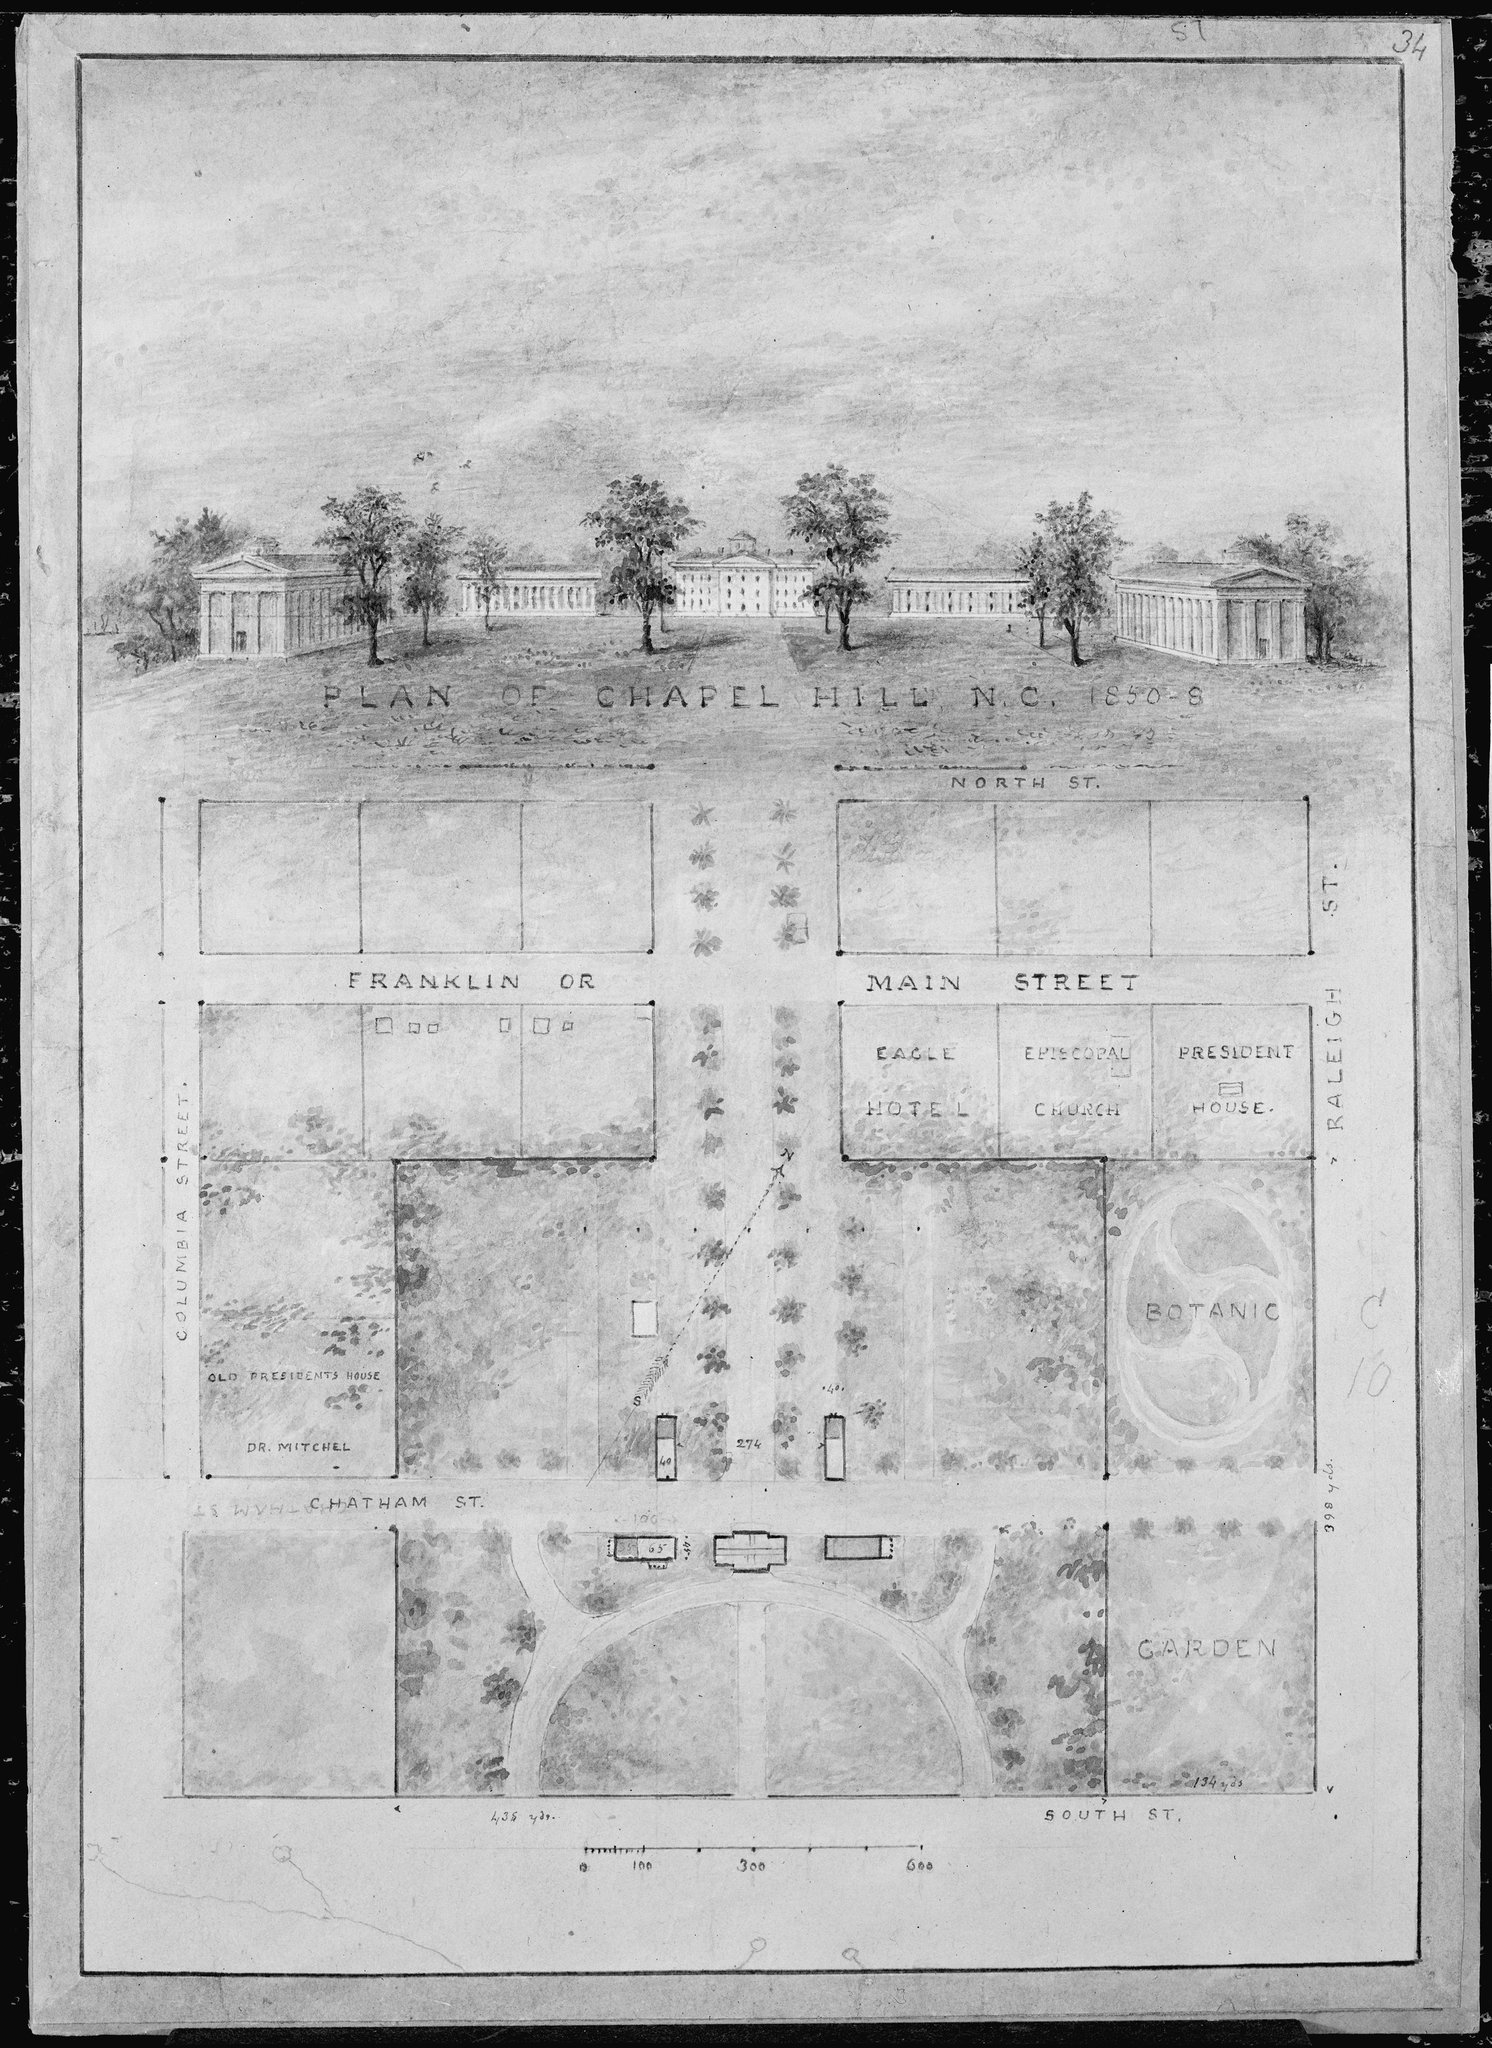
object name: drawing ornament architecture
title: University of North Carolina, Chapel Hill (distant perspective and plan of grounds)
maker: alexander jackson davis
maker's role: artist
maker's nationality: american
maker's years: 1803-1892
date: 1850-1858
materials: graphite, ink, watercolor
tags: architecture,schools